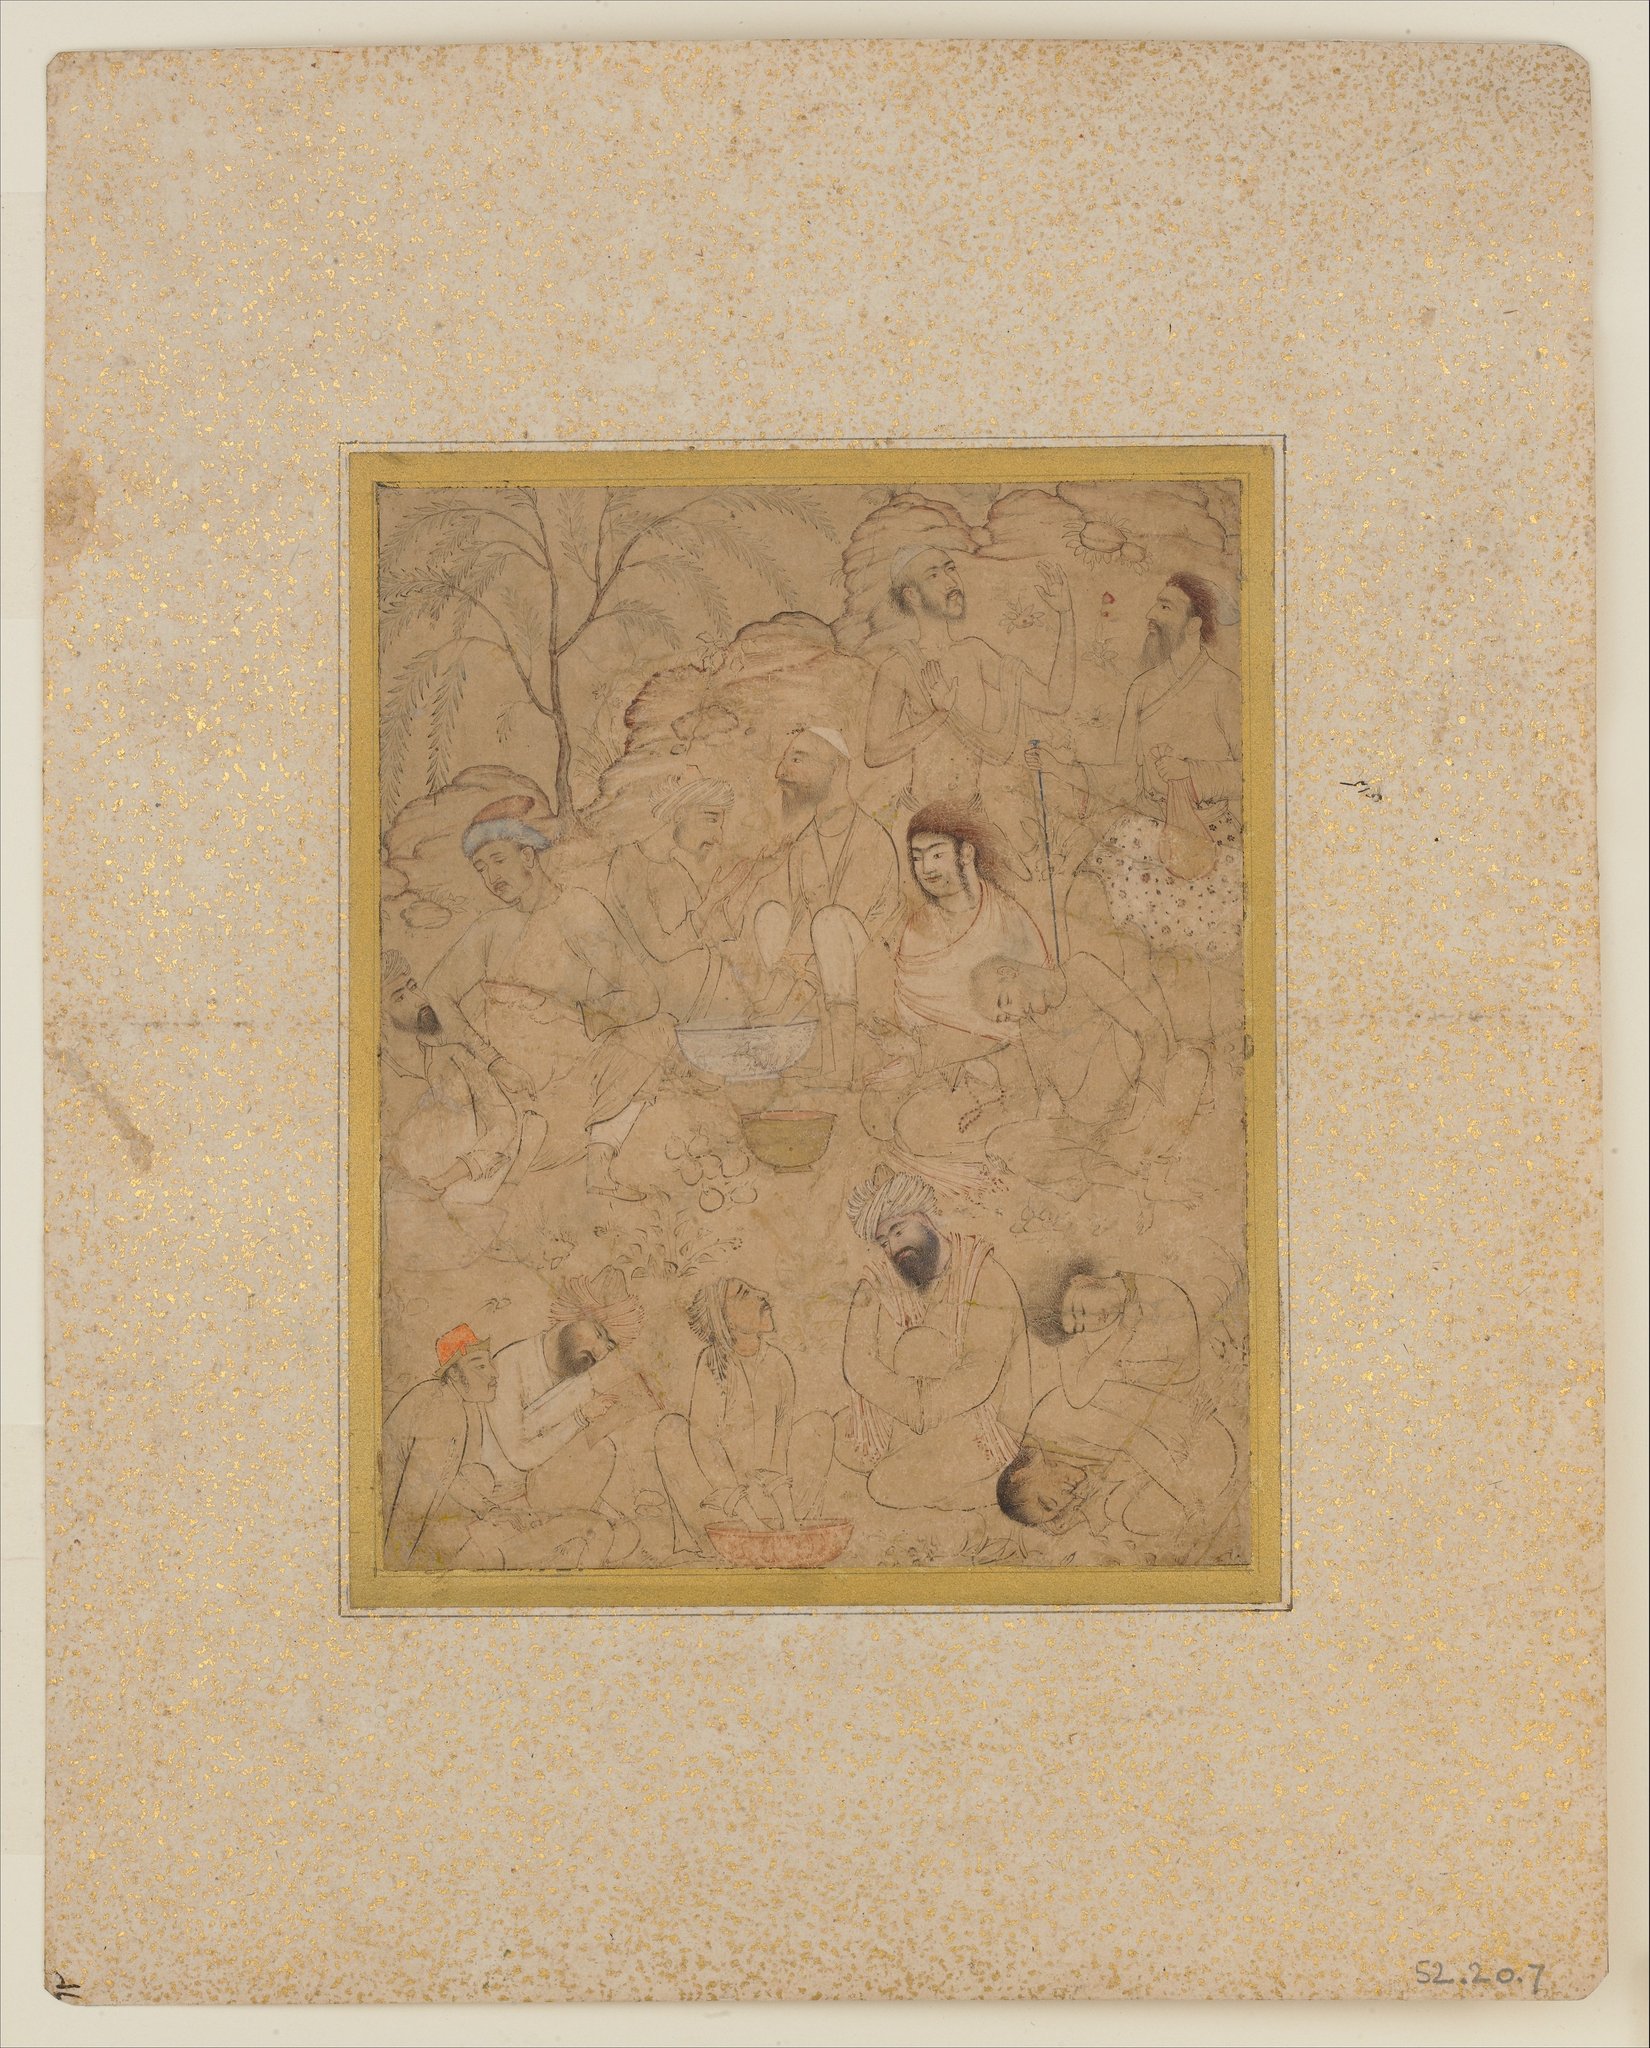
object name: illustrated single work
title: Men Preparing Some Sort of Intoxicant in the Country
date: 1634-1666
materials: ink, paper, watercolor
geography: iran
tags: men,working